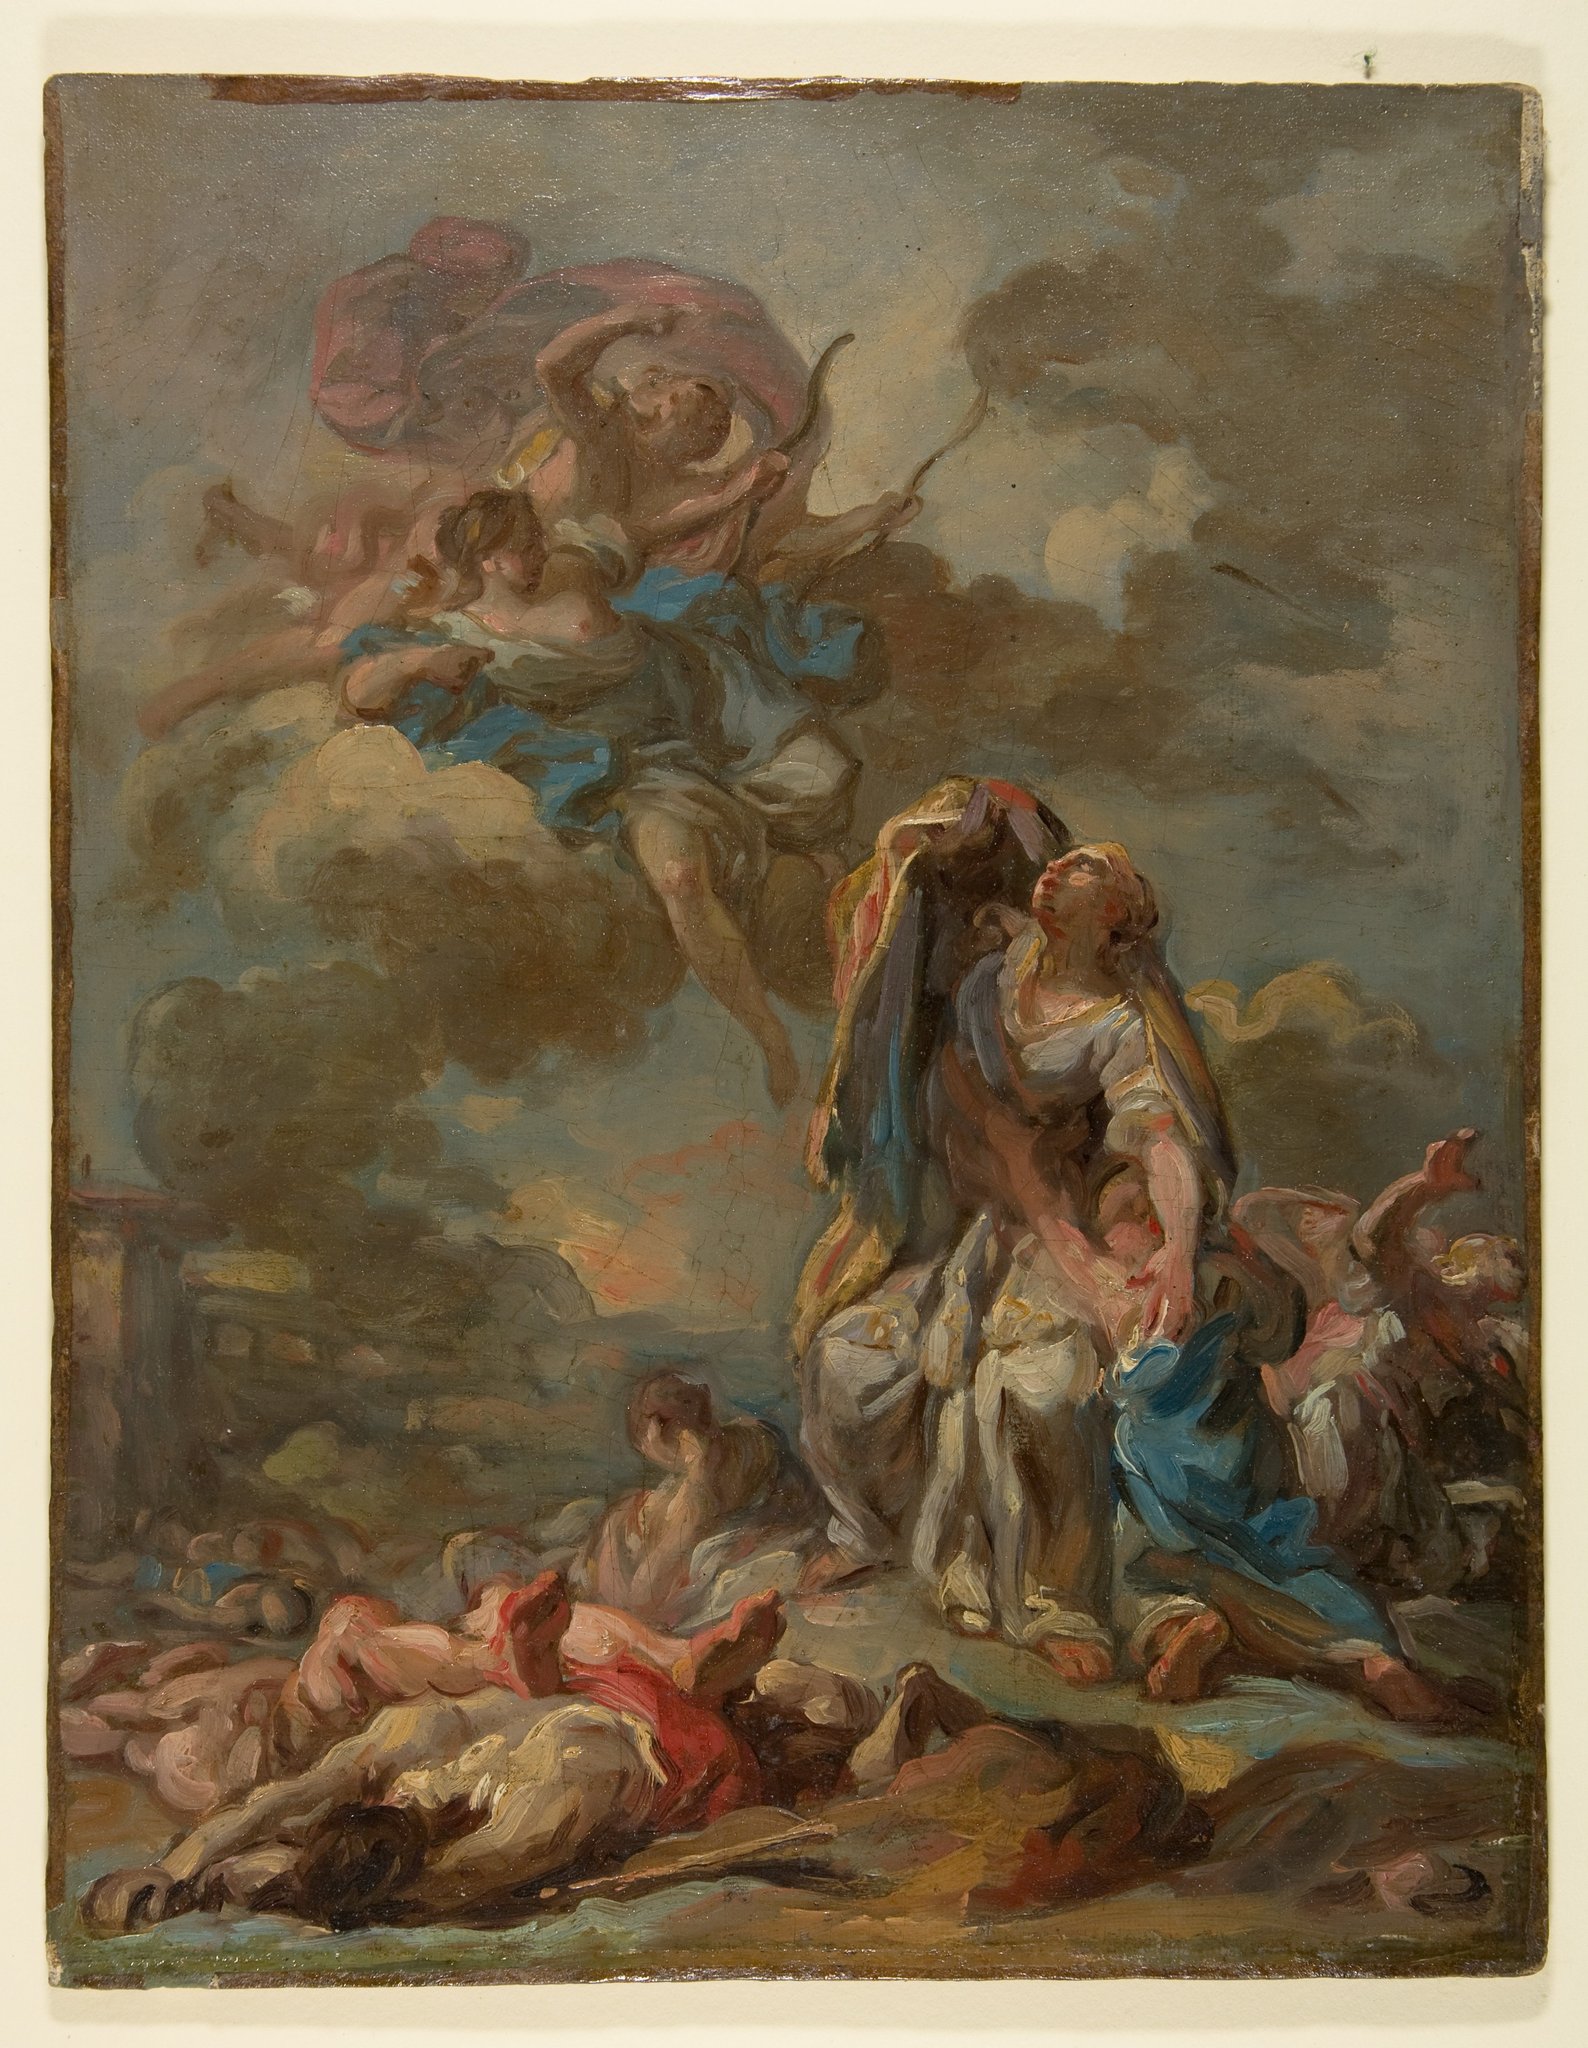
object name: drawing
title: The Punishment of the Arrogant Niobe by Diana and Apollo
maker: pierre charles jombert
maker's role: artist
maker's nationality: french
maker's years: 1748-1825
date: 1772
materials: board, canvas, oil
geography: france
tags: apollo,diana